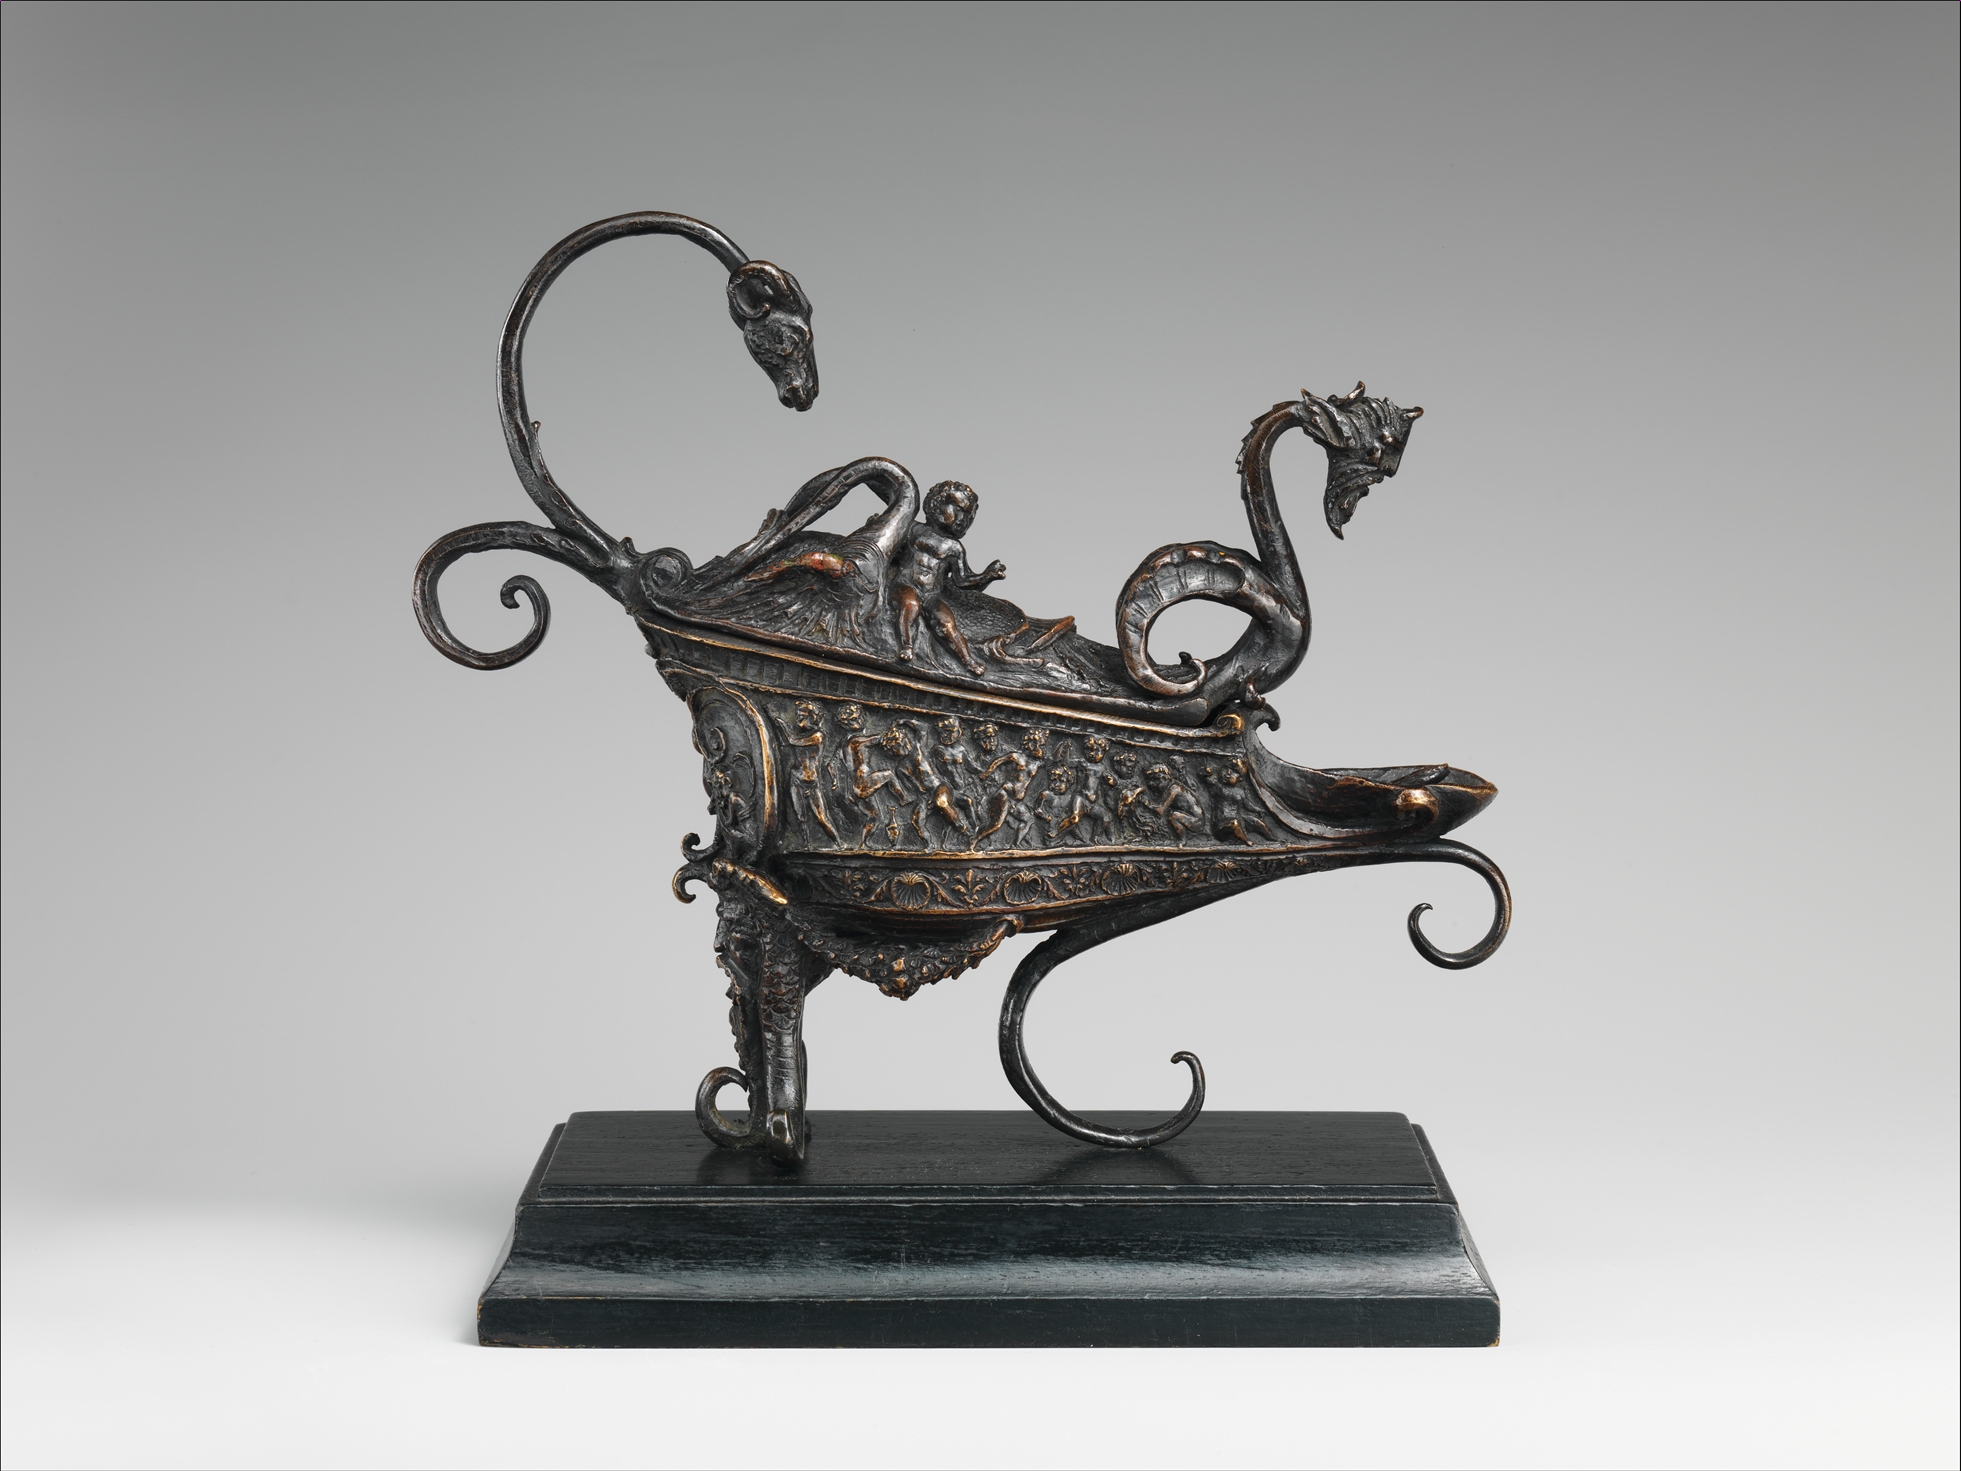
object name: oil lamp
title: Rothschild lamp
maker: andrea briosco, called riccio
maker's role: maker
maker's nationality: italian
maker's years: 1470-1532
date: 1510-1520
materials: bronze, wood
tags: grotesques,putti,rams